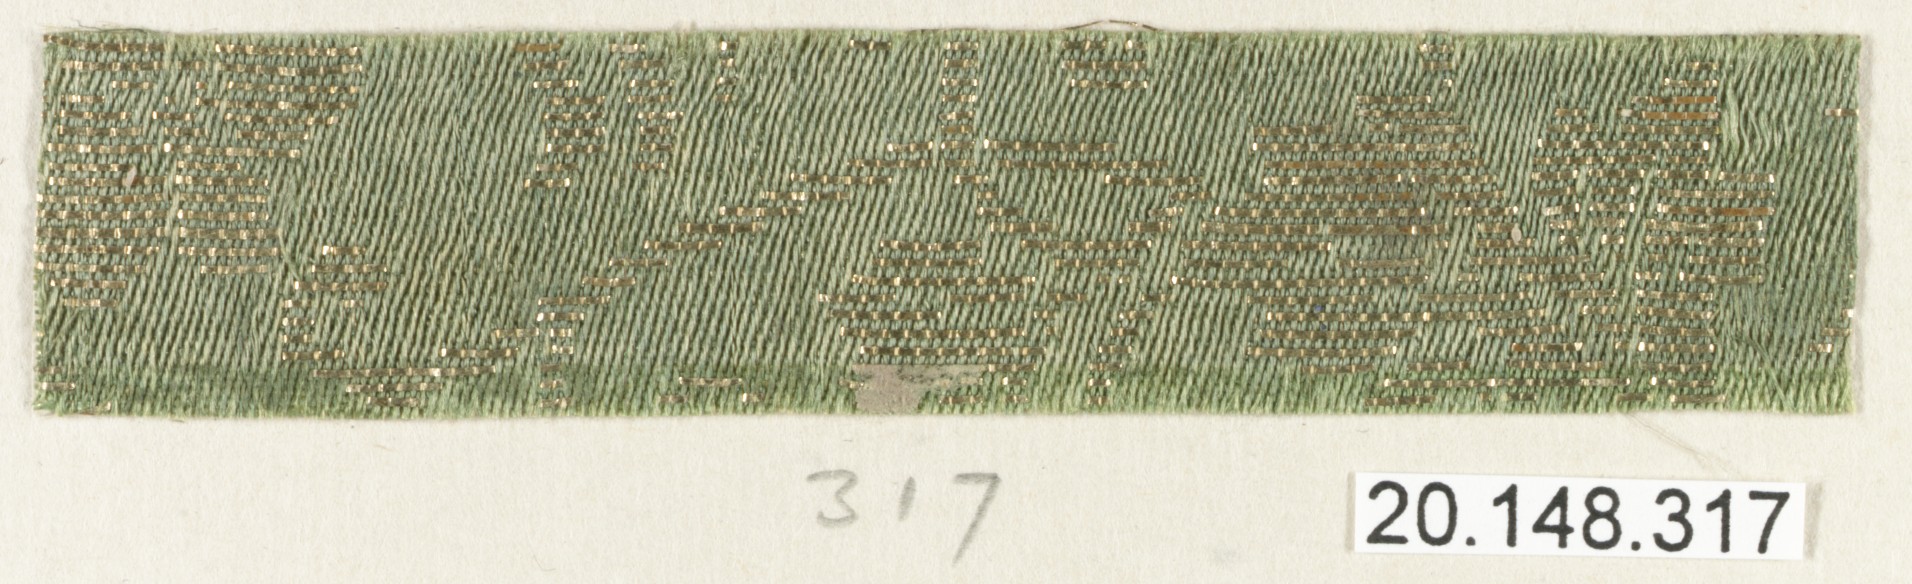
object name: piece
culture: japanese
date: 1601-1700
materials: silk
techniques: compound weave